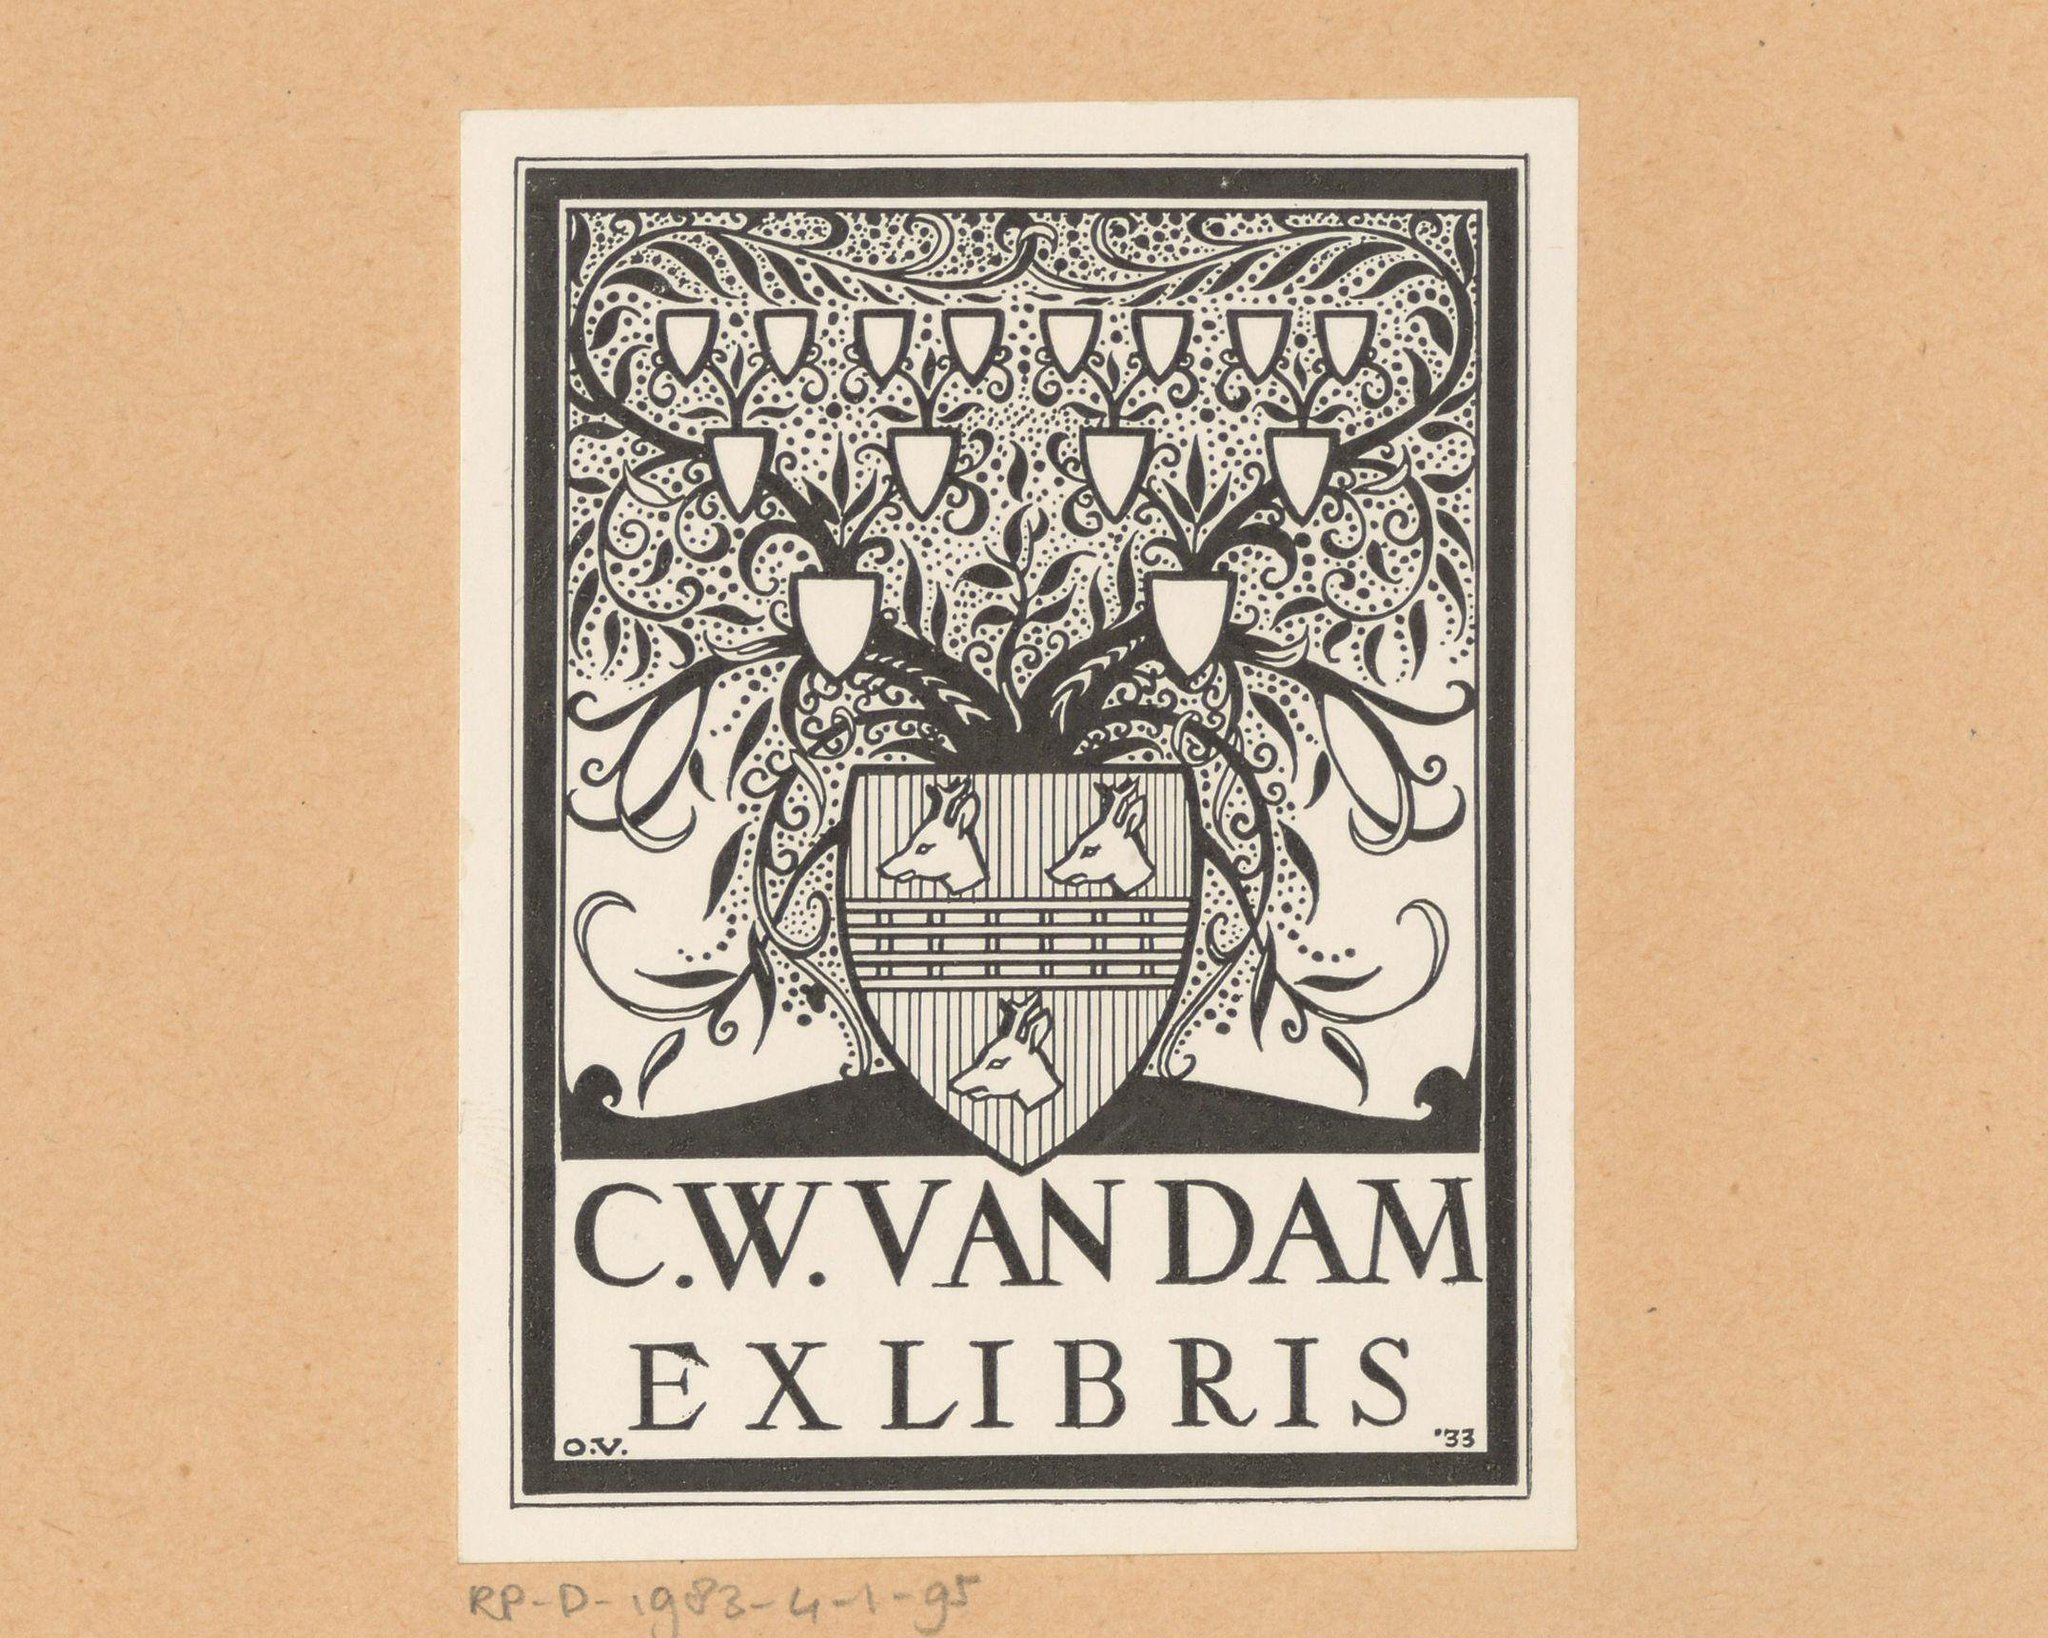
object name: bookplate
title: Ex libris van C.W. van Dam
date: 1933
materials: paper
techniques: printing block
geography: netherlands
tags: trees, hoofed animals: deer, armorial bearing, heraldry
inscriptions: inscription: ‘Clichédruk/ Jaar 1933 motief - heraldiek.’